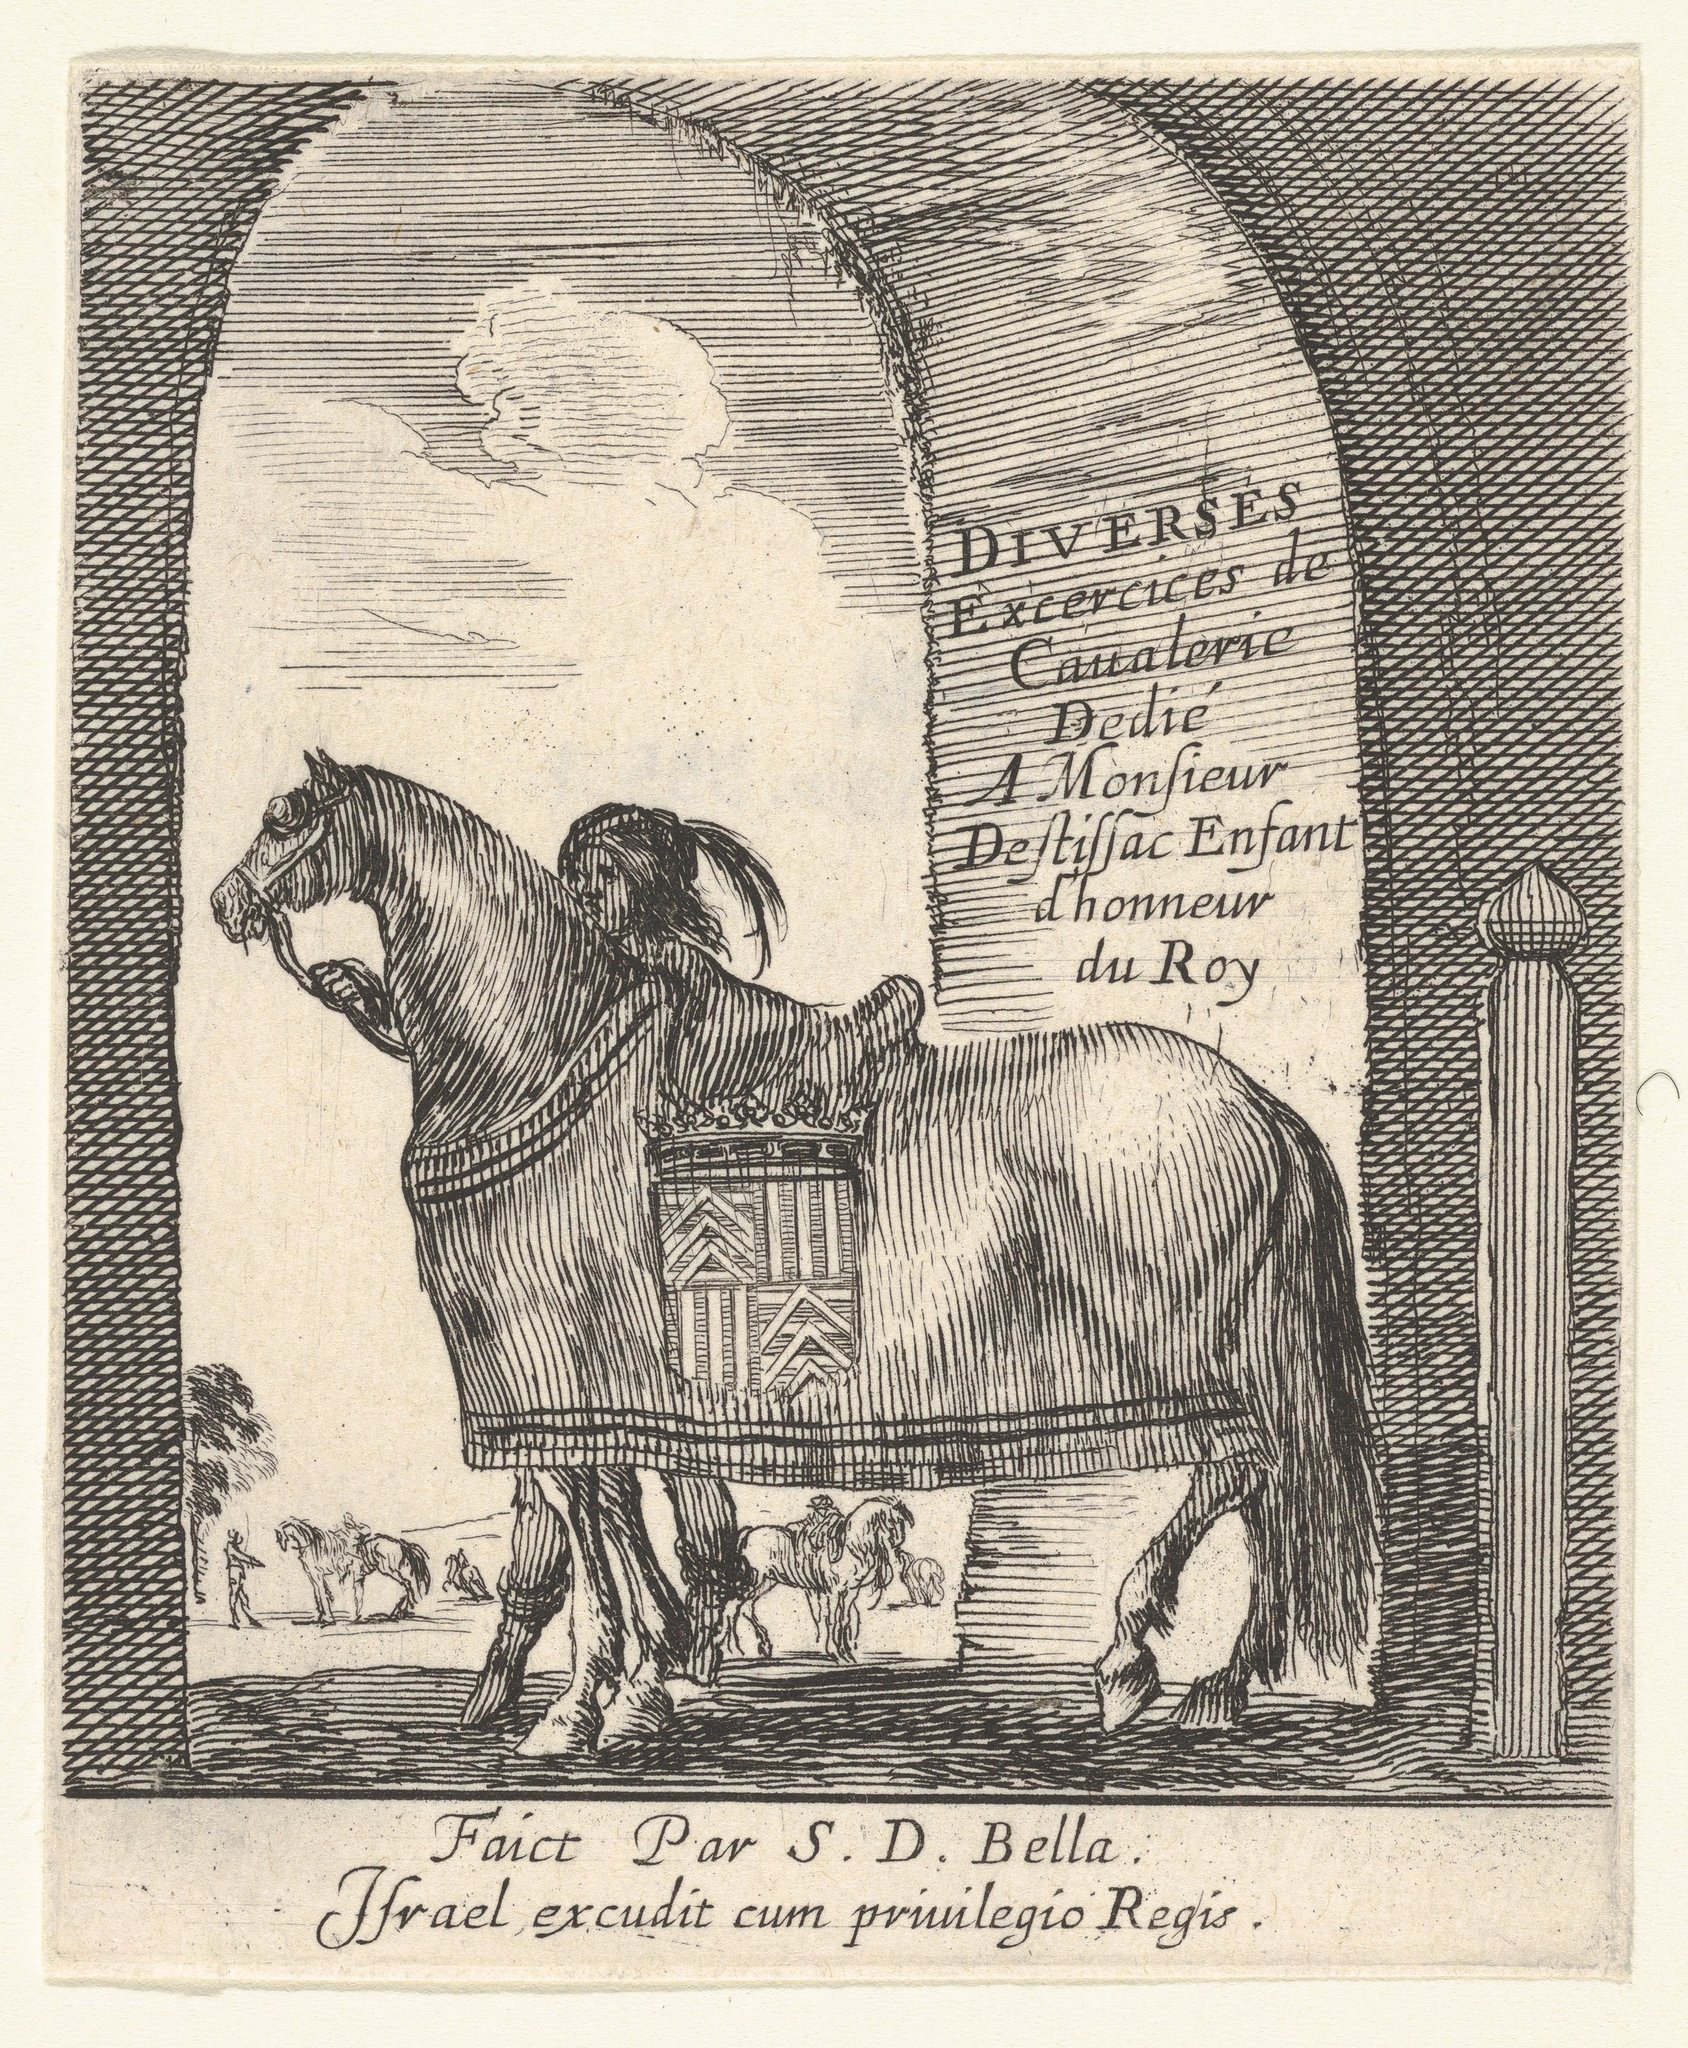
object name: print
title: Beneath an archway, a groom holds the bridle of a horse shown in profile, facing left, the title page for "Various cavalry exercises" (Diverses exercices de cavalerie)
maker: stefano della bella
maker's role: artist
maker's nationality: italian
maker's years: 1610-1664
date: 1642-1645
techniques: etching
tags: men,horses,coat of arms